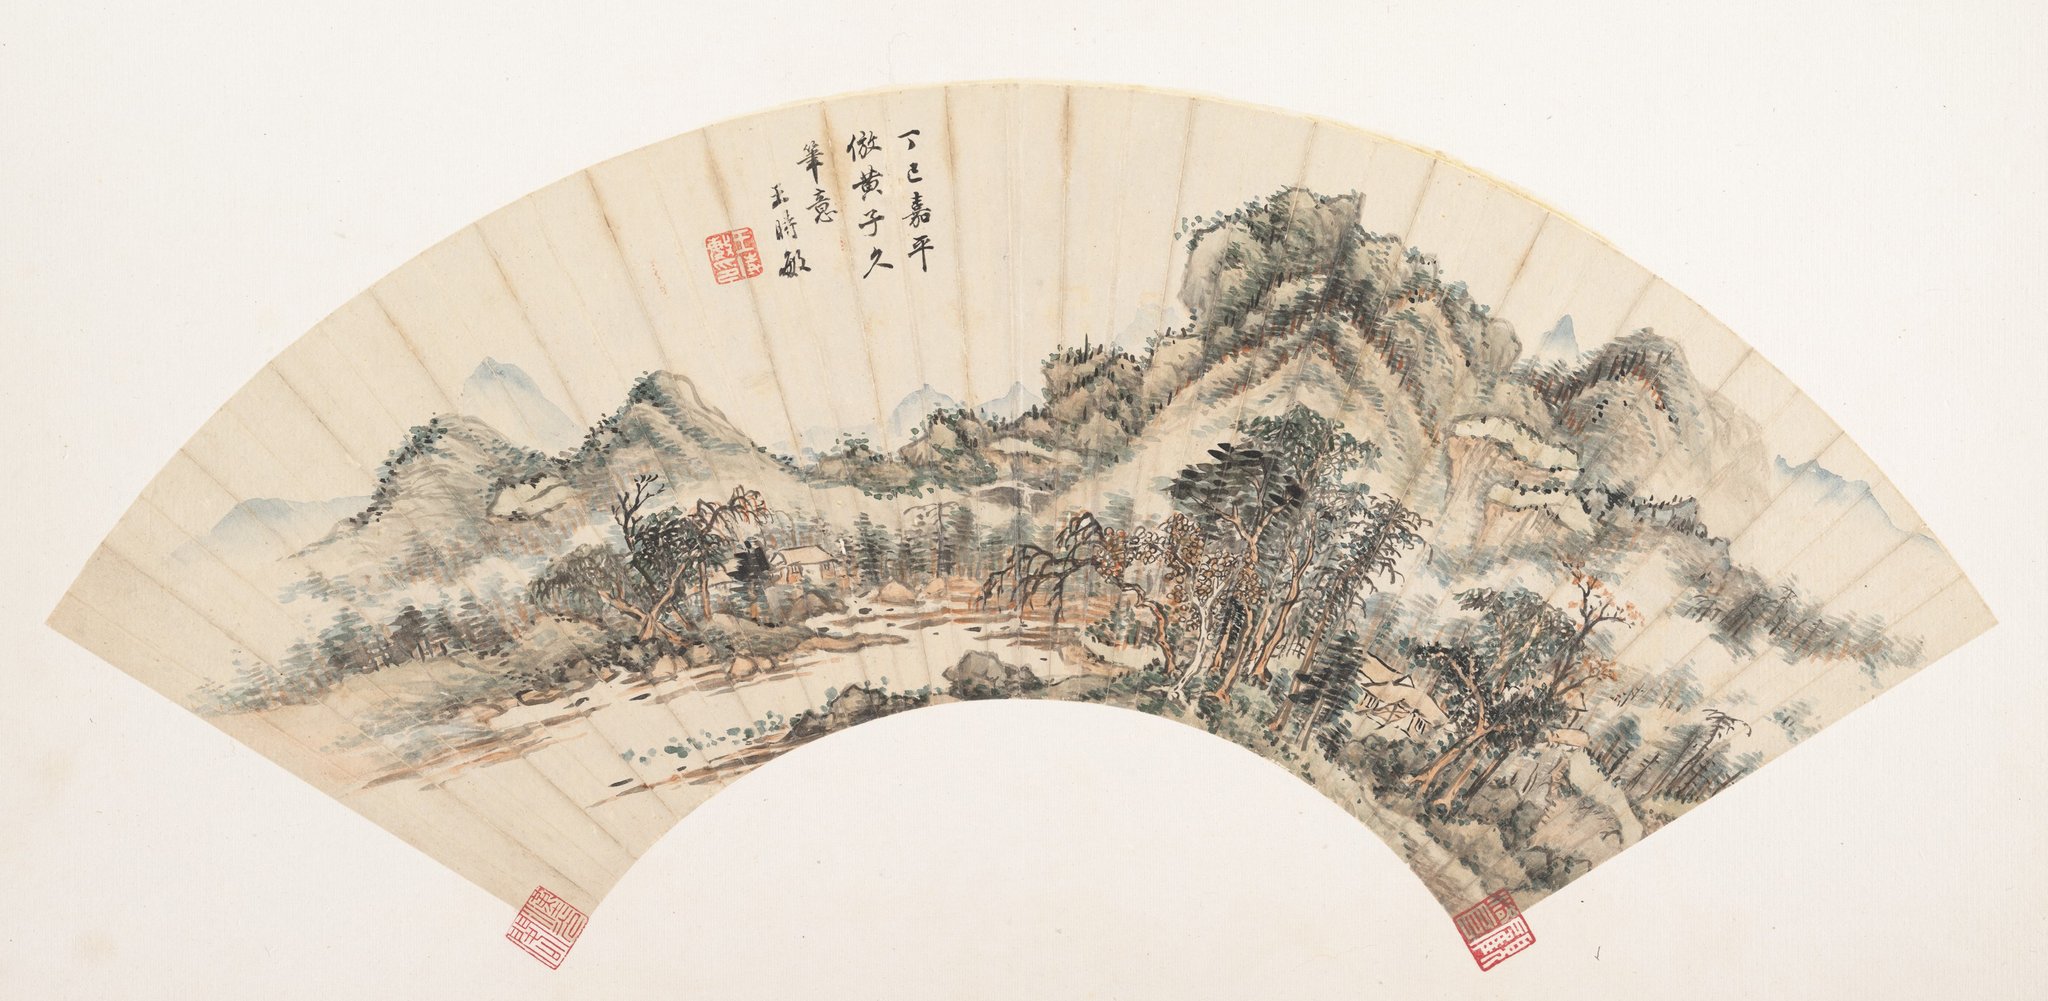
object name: folding fan mounted a an album leaf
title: Landscape after Huang Gongwang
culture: chinese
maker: wang shimin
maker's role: artist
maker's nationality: chinese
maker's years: 1592-1680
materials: ink, paper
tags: mountains,landscapes